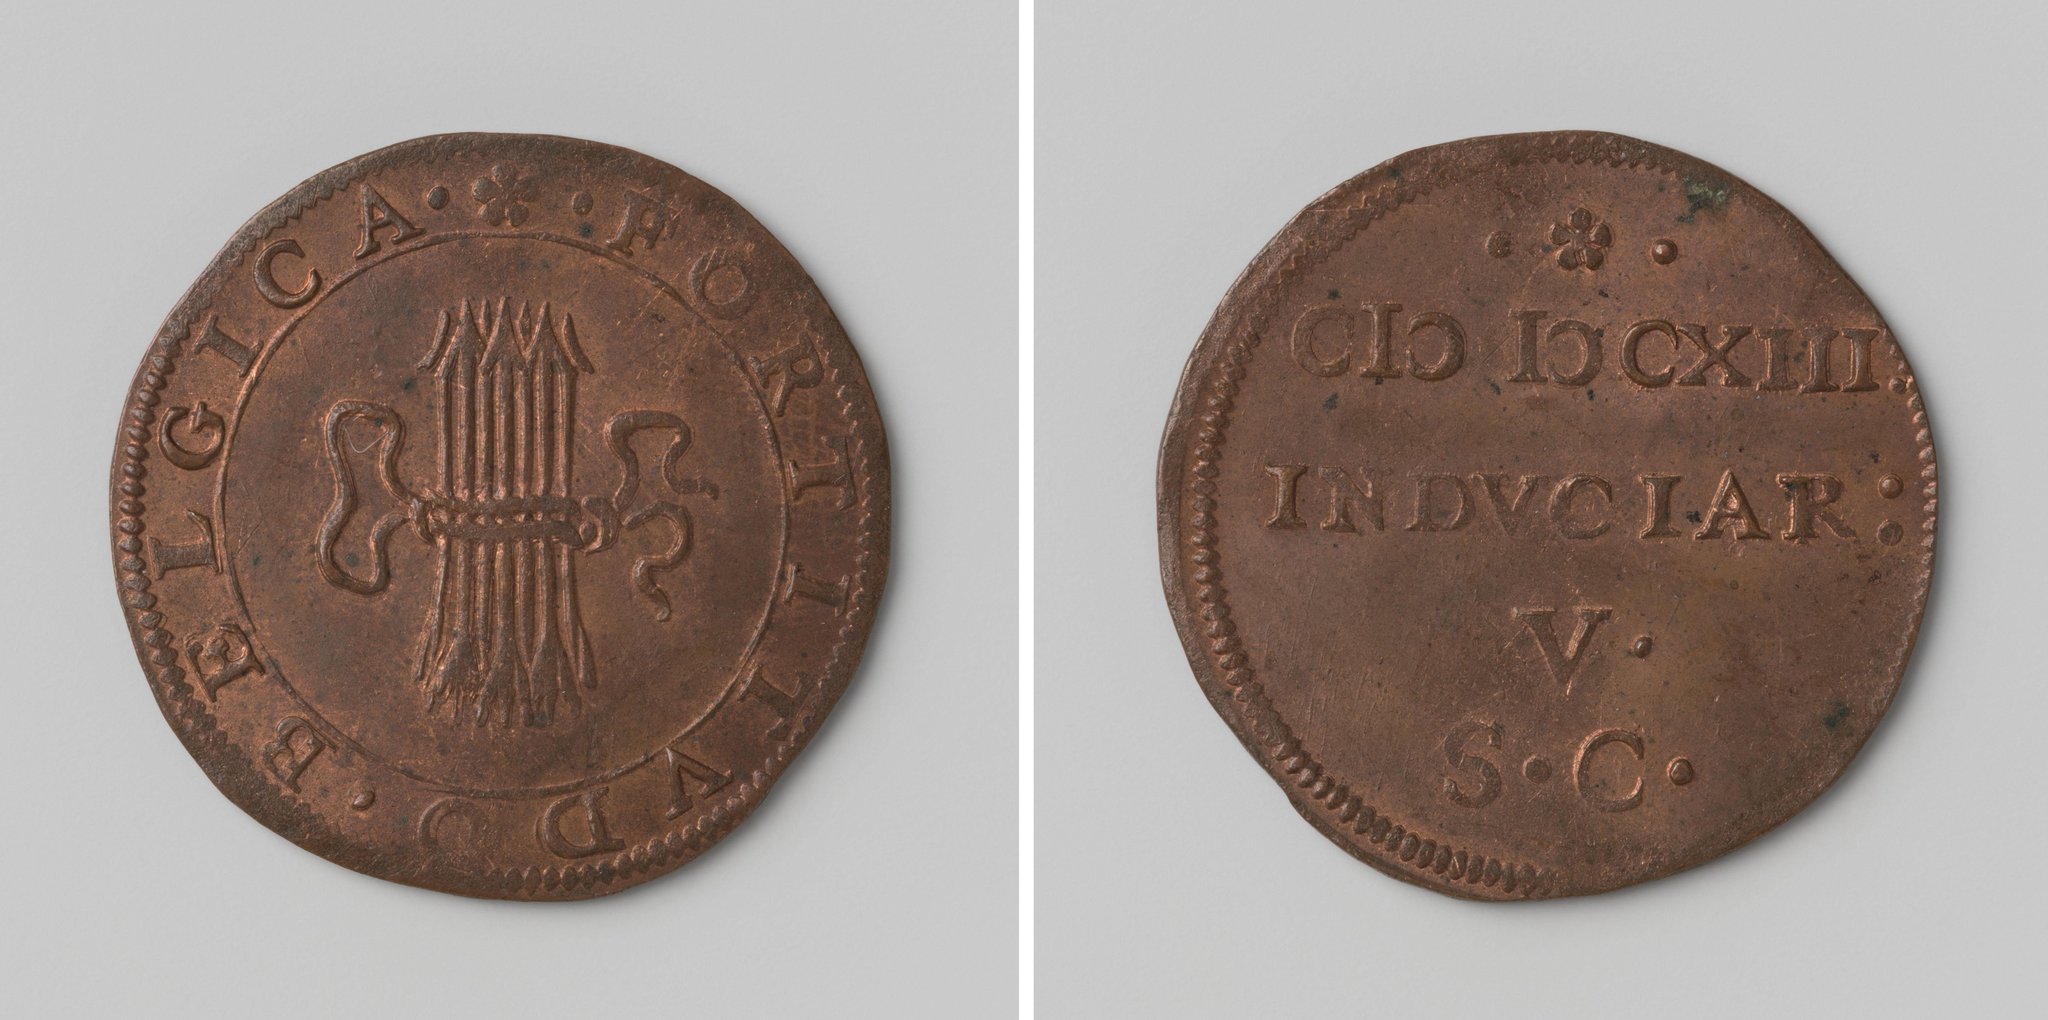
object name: jeton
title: Macht van de Zeven Verenigde Nederlanden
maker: Anonymous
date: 1613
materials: copper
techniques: striking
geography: dordrecht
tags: netherlands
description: Koperen penning. Voorzijde: bundel van zee met lint samengebonden pijlen binnen omschrift. Keerzijde: opschrift